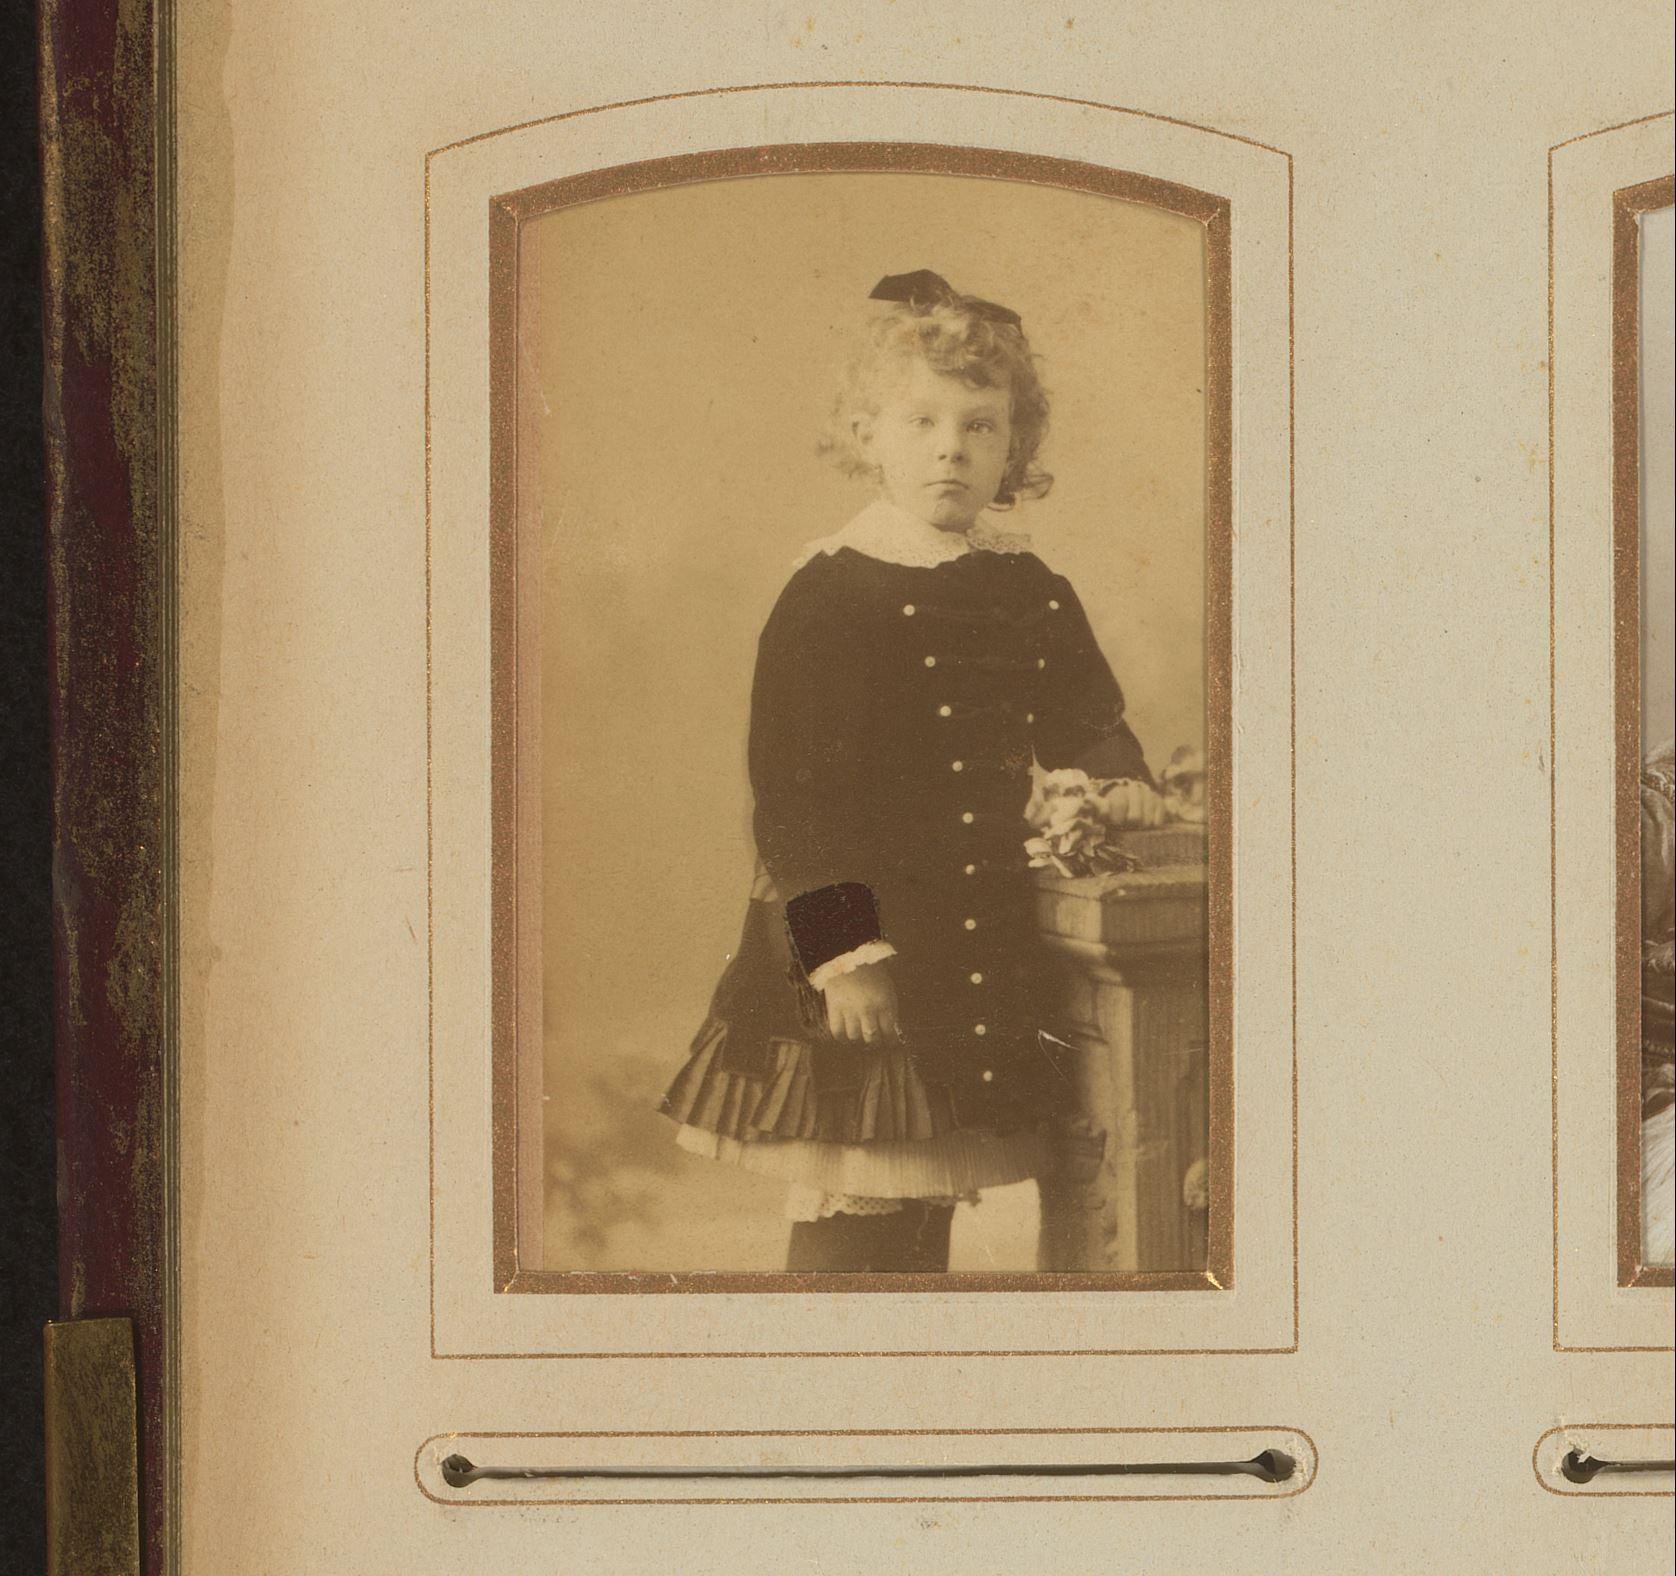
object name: photograph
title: Portret van een meisje, staand bij een zuil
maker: max büttinghausen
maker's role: fotograaf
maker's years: 1847-1906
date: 1873-1886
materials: cardboard, photographic support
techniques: albumen print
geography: amsterdam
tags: historical persons - bb - woman, girl (child between toddler and youth), pedestal of a piece of sculpture (perhaps in the form of a herm)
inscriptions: inscription: ‘M. Büttinghausen/ Photografisch artistisch Atelier/ Amsterdam/ Singel bij het Koningsplein No. 512.’